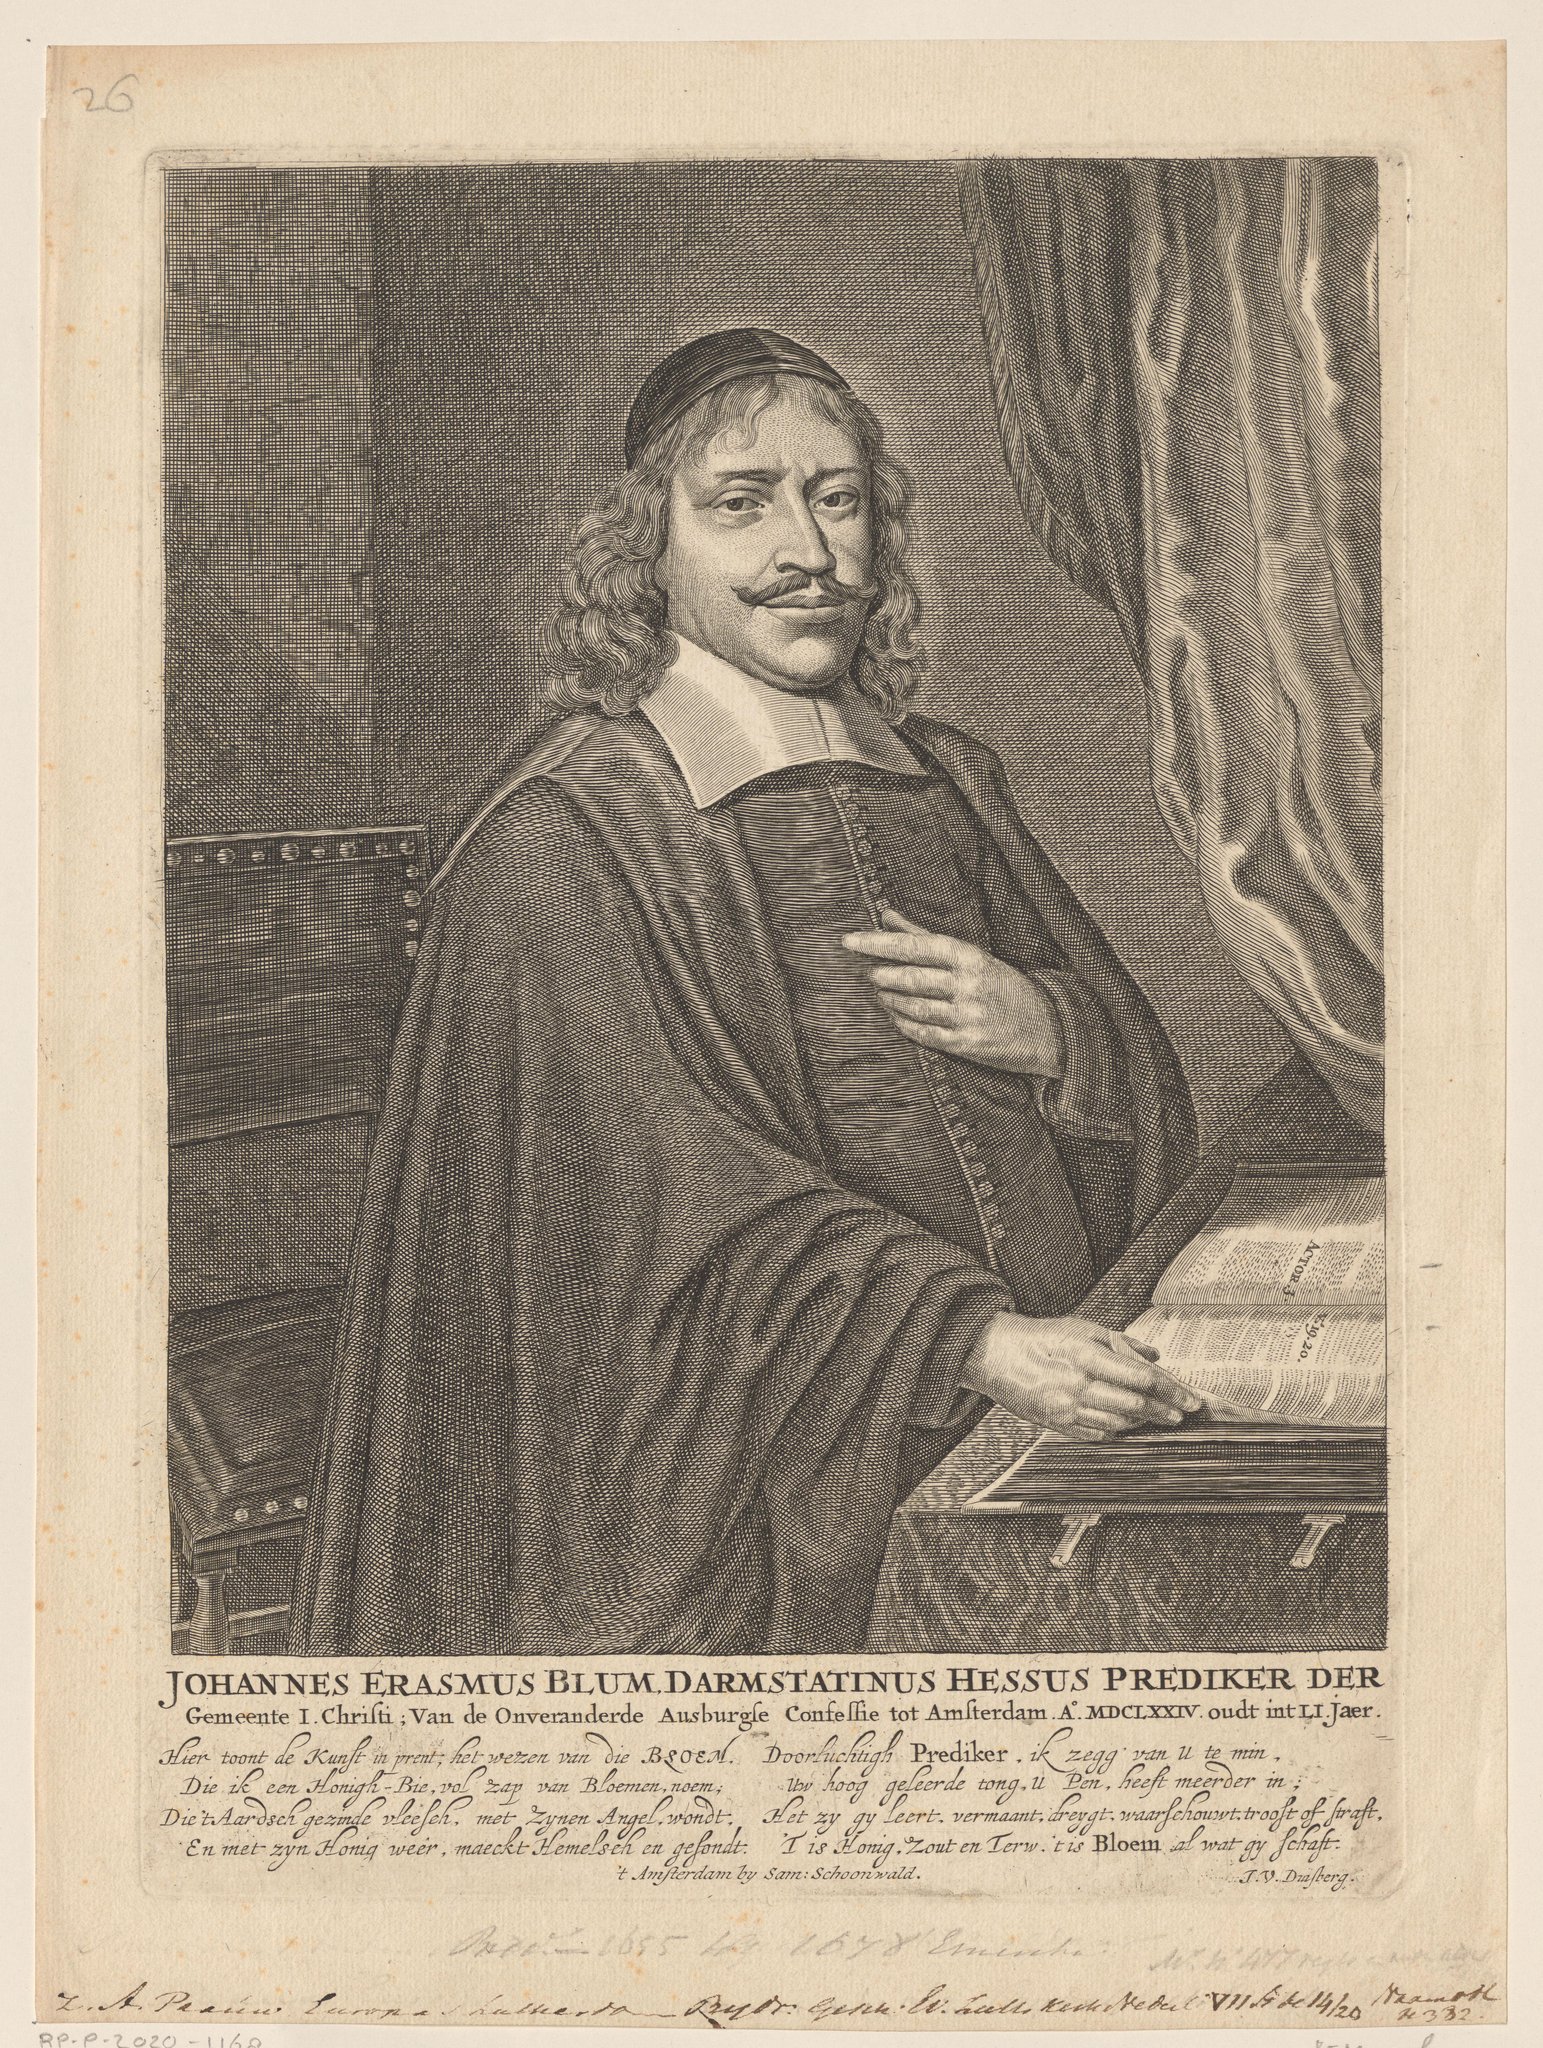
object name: print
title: Johannes Erasmus Blum Darmstatinus Hessus prediker (...)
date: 1712-1740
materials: paper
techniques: engraving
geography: amsterdam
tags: amsterdam, theologian, historical persons, book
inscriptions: inscription: ‘[...]’